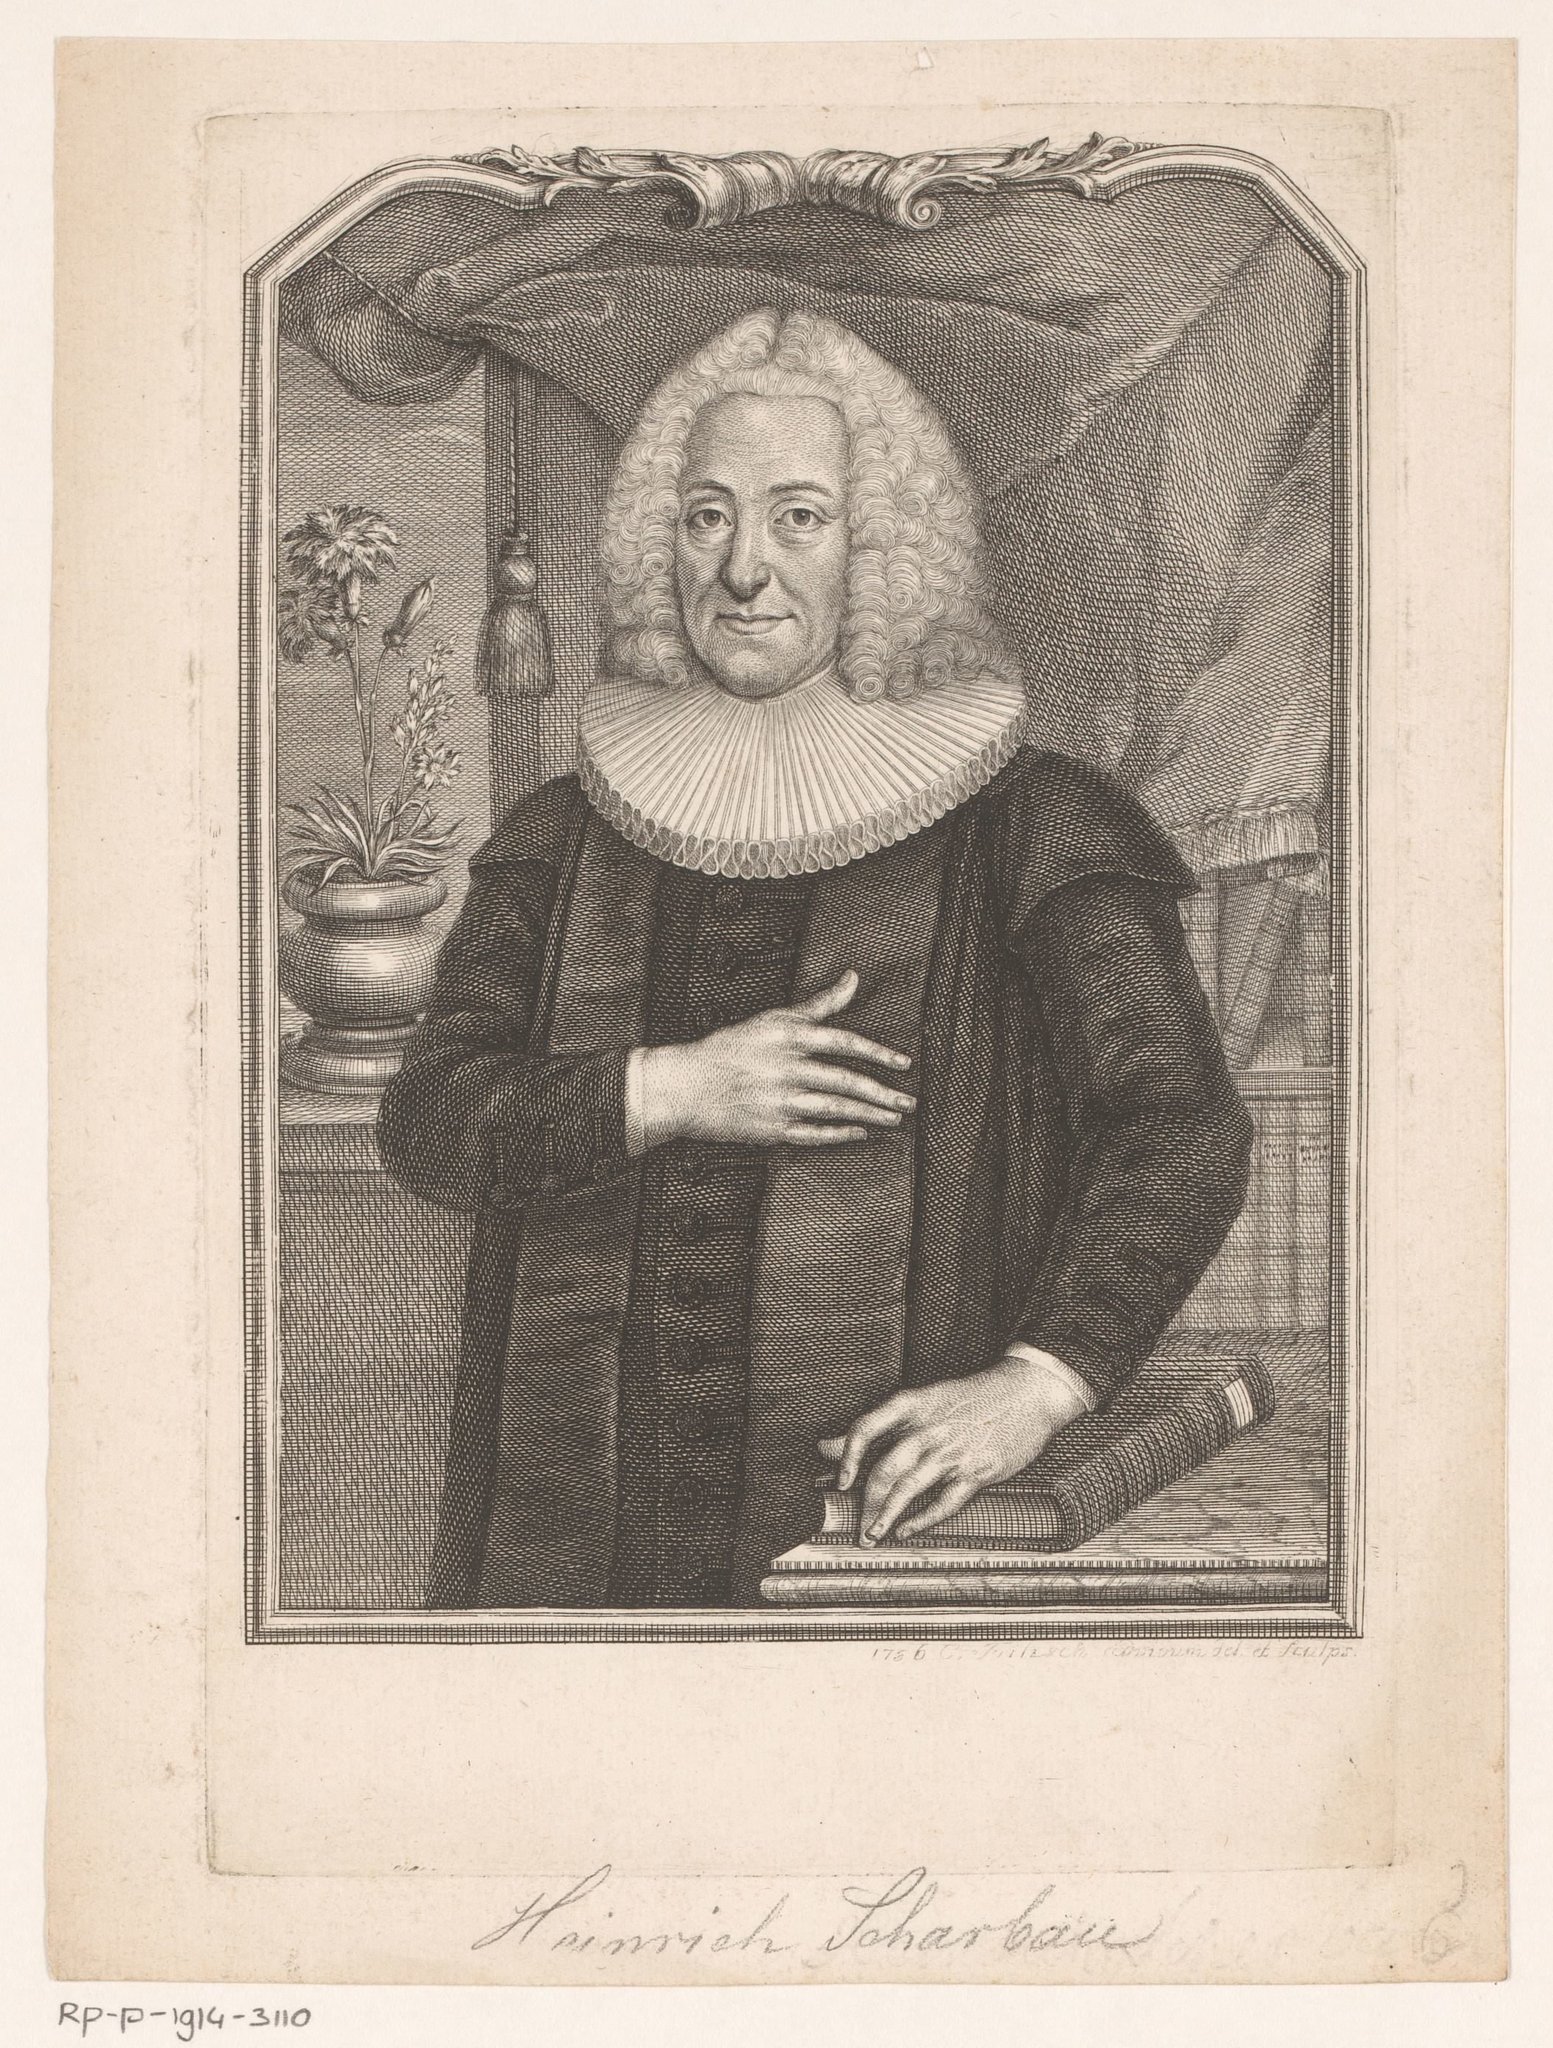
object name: print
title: Portret van Heinrich Scharbau op 68-jarige leeftijd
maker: christian fritzsch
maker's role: print maker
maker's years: 1695-1769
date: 1756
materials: paper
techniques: engraving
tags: flowers, bookshelves, historical persons, book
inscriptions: collector's mark: Lugt 2228